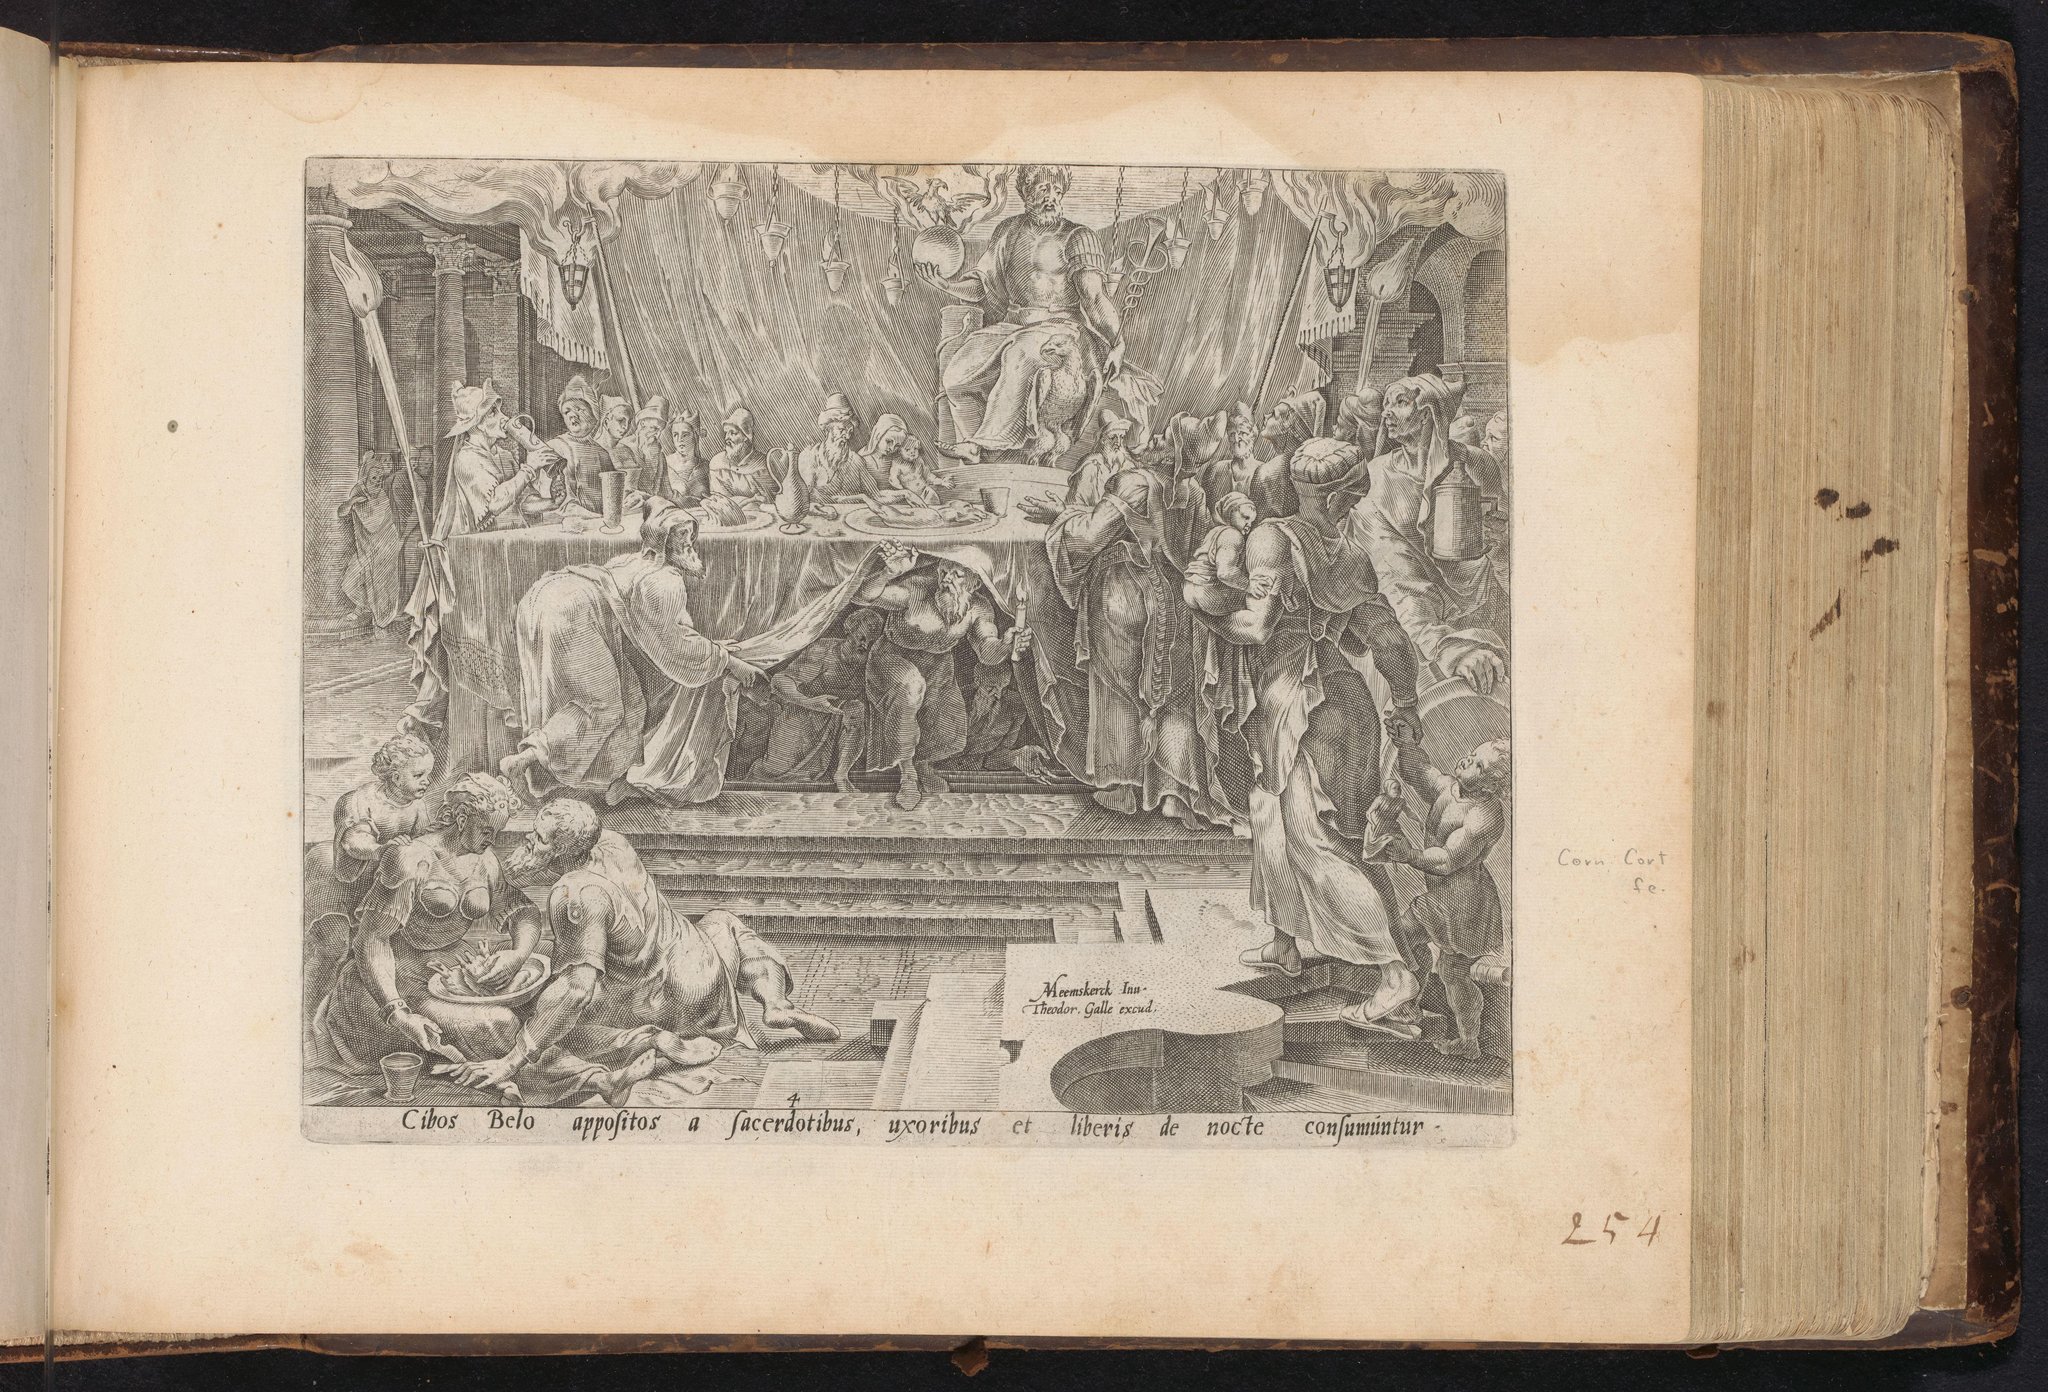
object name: print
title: Geschiedenis van Daniël, Bel en de draak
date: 1565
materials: paper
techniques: engraving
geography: amsterdam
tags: the priests of bel, with their wives and children, enter the temple through a hidden corridor and feast on the food during the night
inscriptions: number: ‘254’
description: De priesters van Bel eten het aan de god Bel geofferde voedsel. Ze komen en gaan door een geheime gang onder de tafel. Terwijl ze heimelijk het voedsel nemen, blijven hun voetstappen achter in de door Daniël op de grond gestrooide as. Onder de voorstelling een verklarende tekst in het Latijn. Prent maakt deel uit van een album.